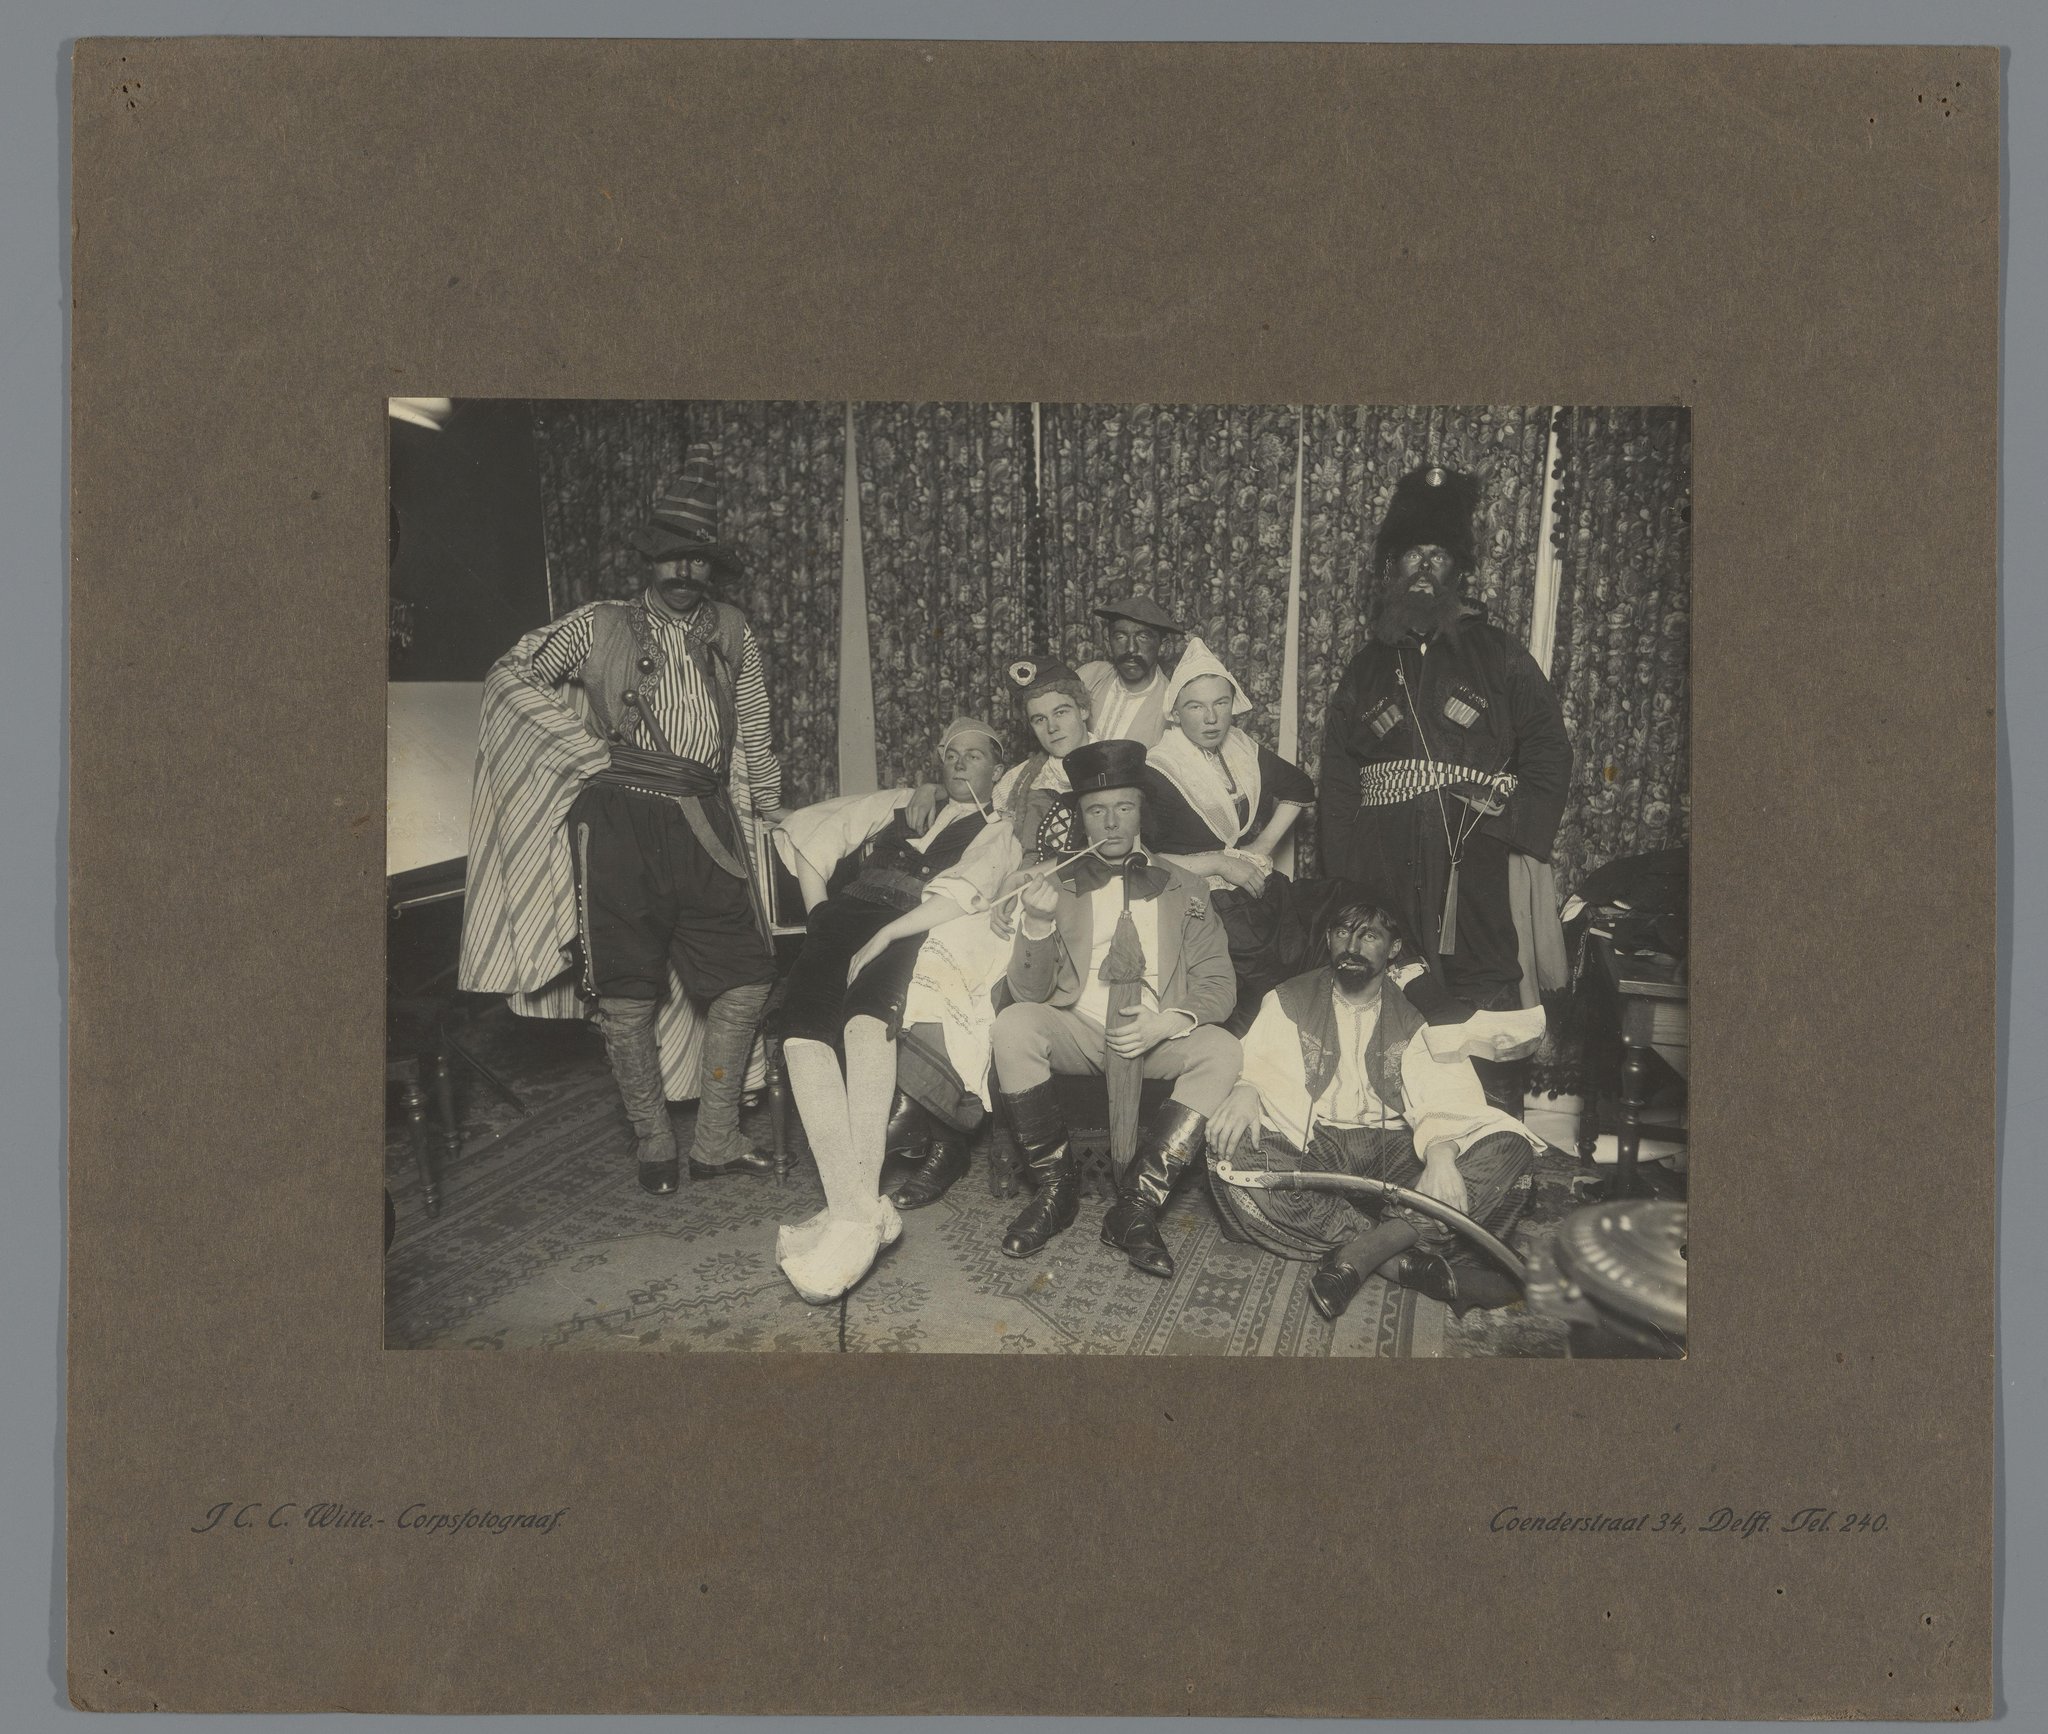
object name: photograph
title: Groepsportret van verklede studenten tijdens een kroegdiës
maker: j.c.c. witte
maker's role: fotograaf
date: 1915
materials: paper, cardboard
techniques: gelatin silver print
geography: delft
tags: rowing facing backward, pulling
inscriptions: inscription: ‘Kroegdiës/ 1914 ?/ Schill/ [...]’, address: ‘J.C.C. Witte. -Corpsfotograaf. Coenderstraat 34, Delft. Tel. 240.’